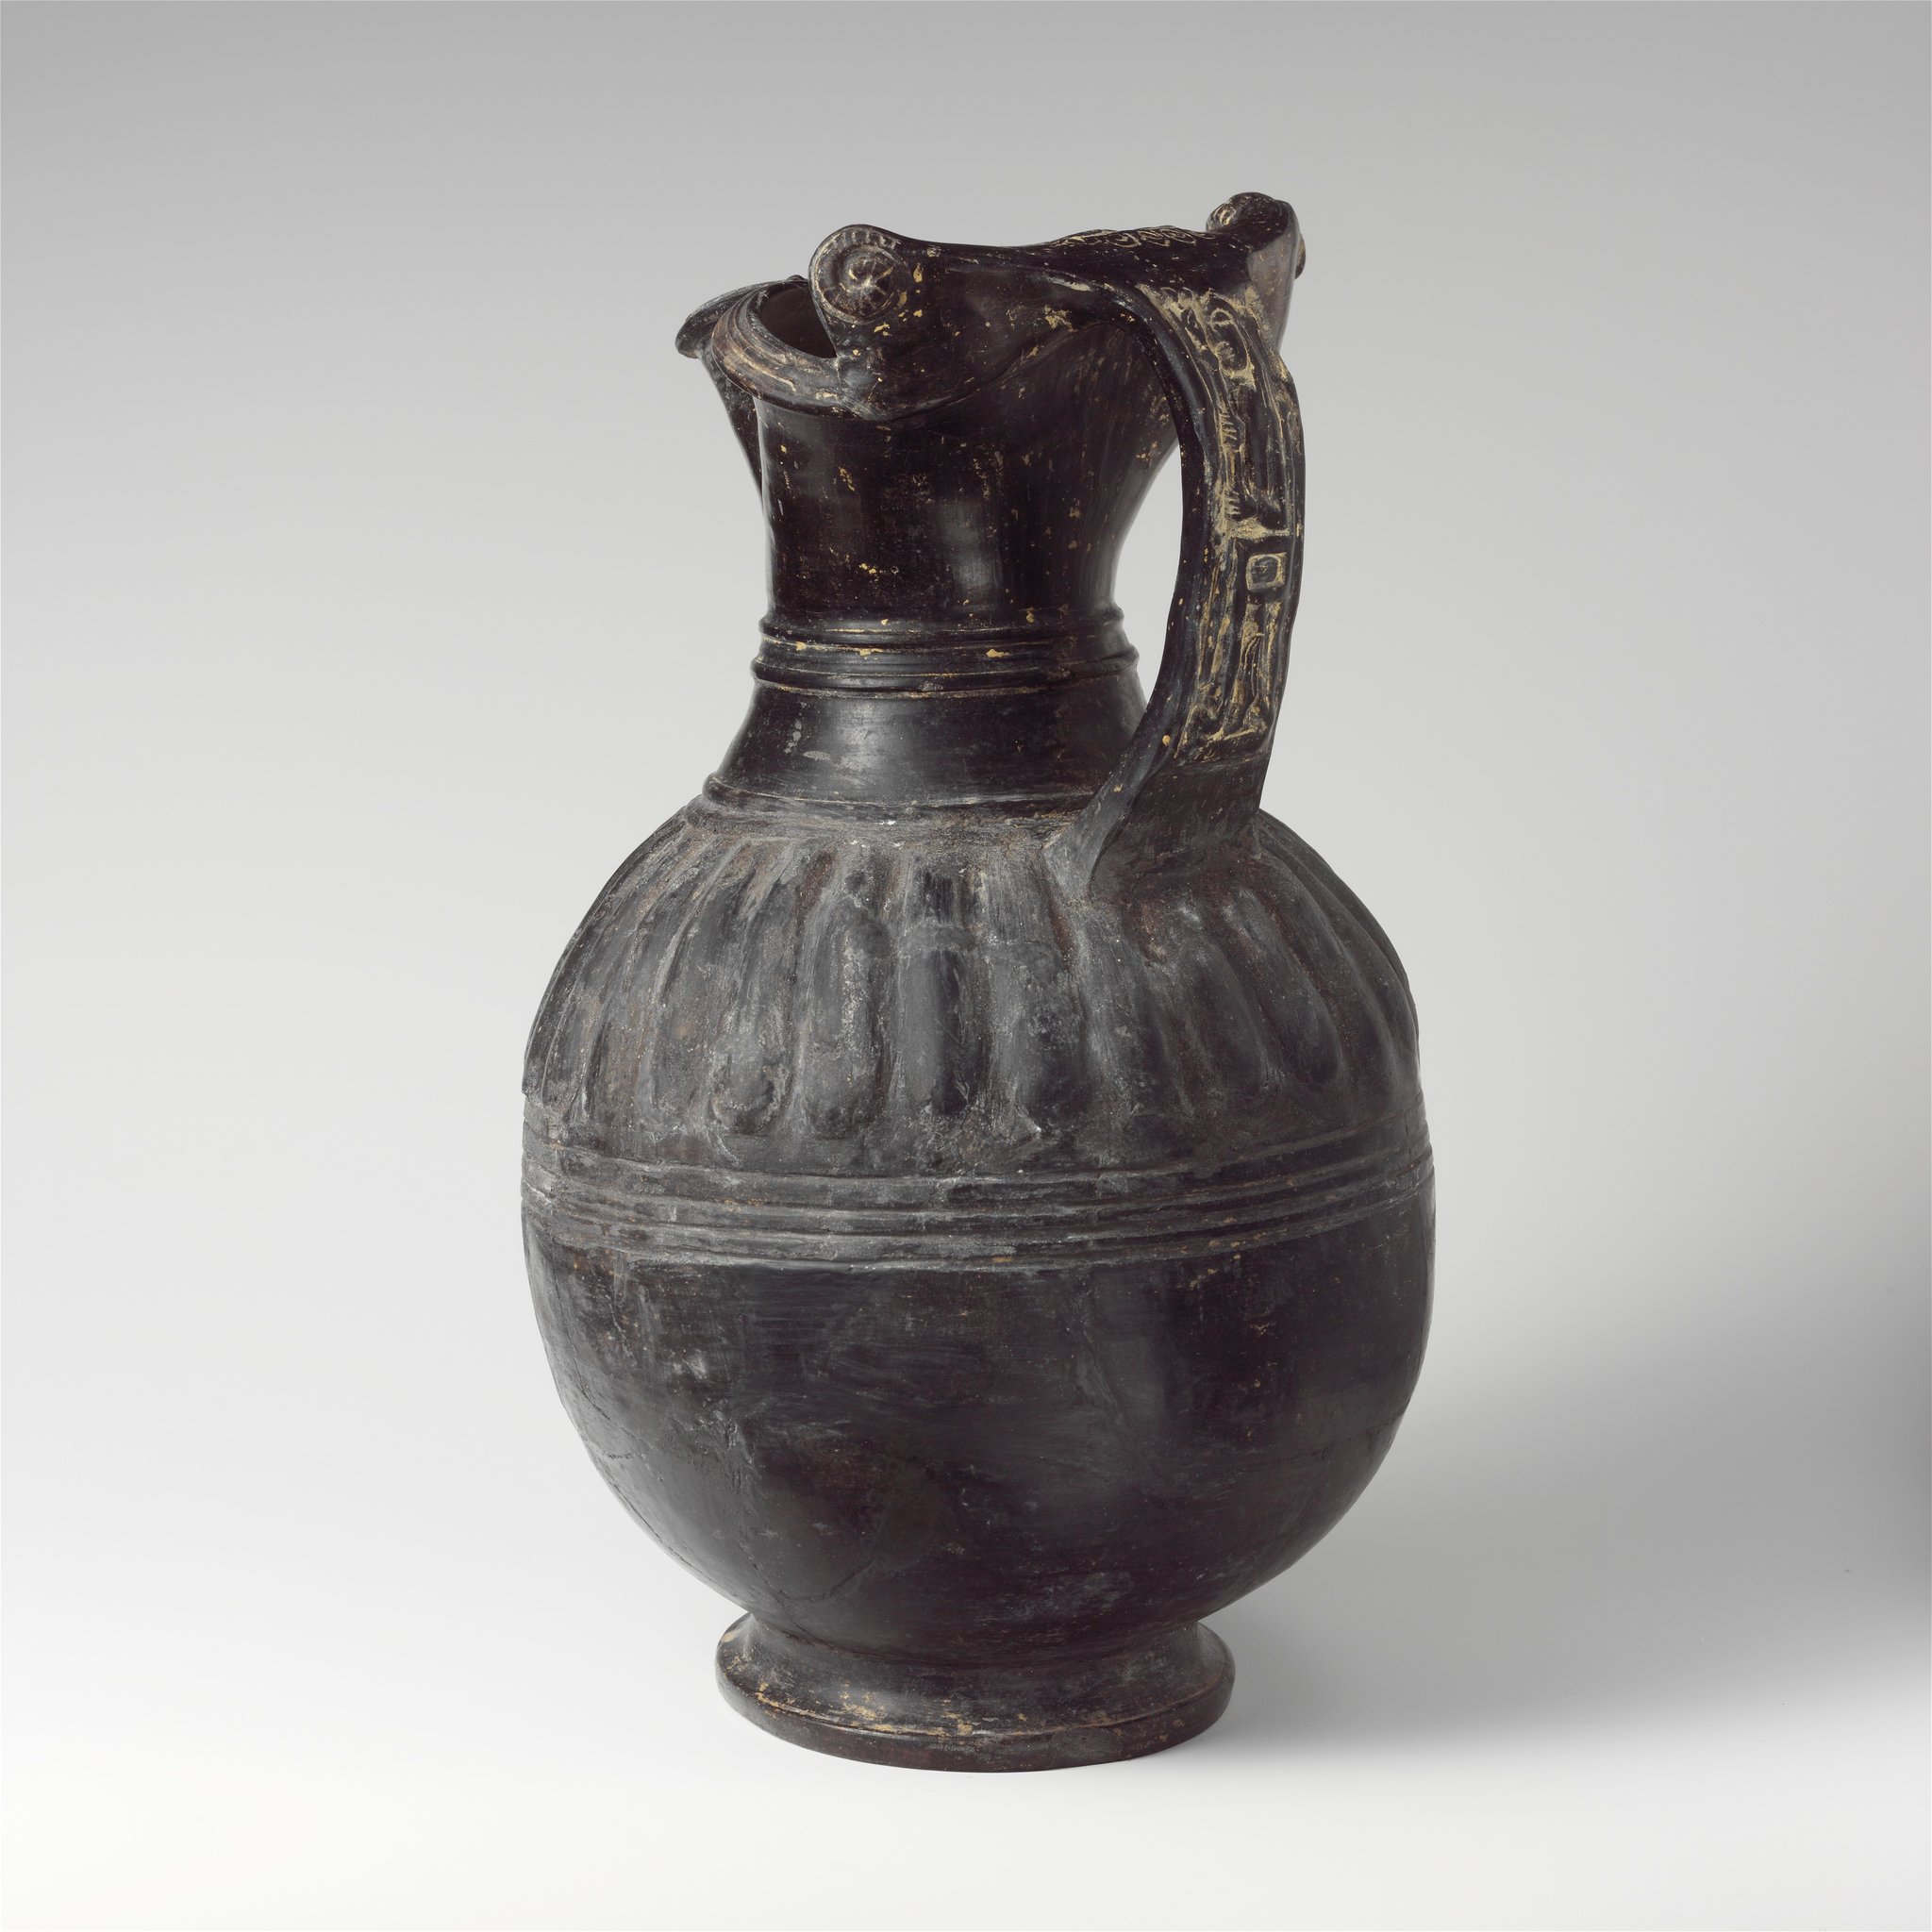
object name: jug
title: Terracotta trefoil oinochoe (jug)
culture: etruscan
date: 525-500 BCE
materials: terracotta